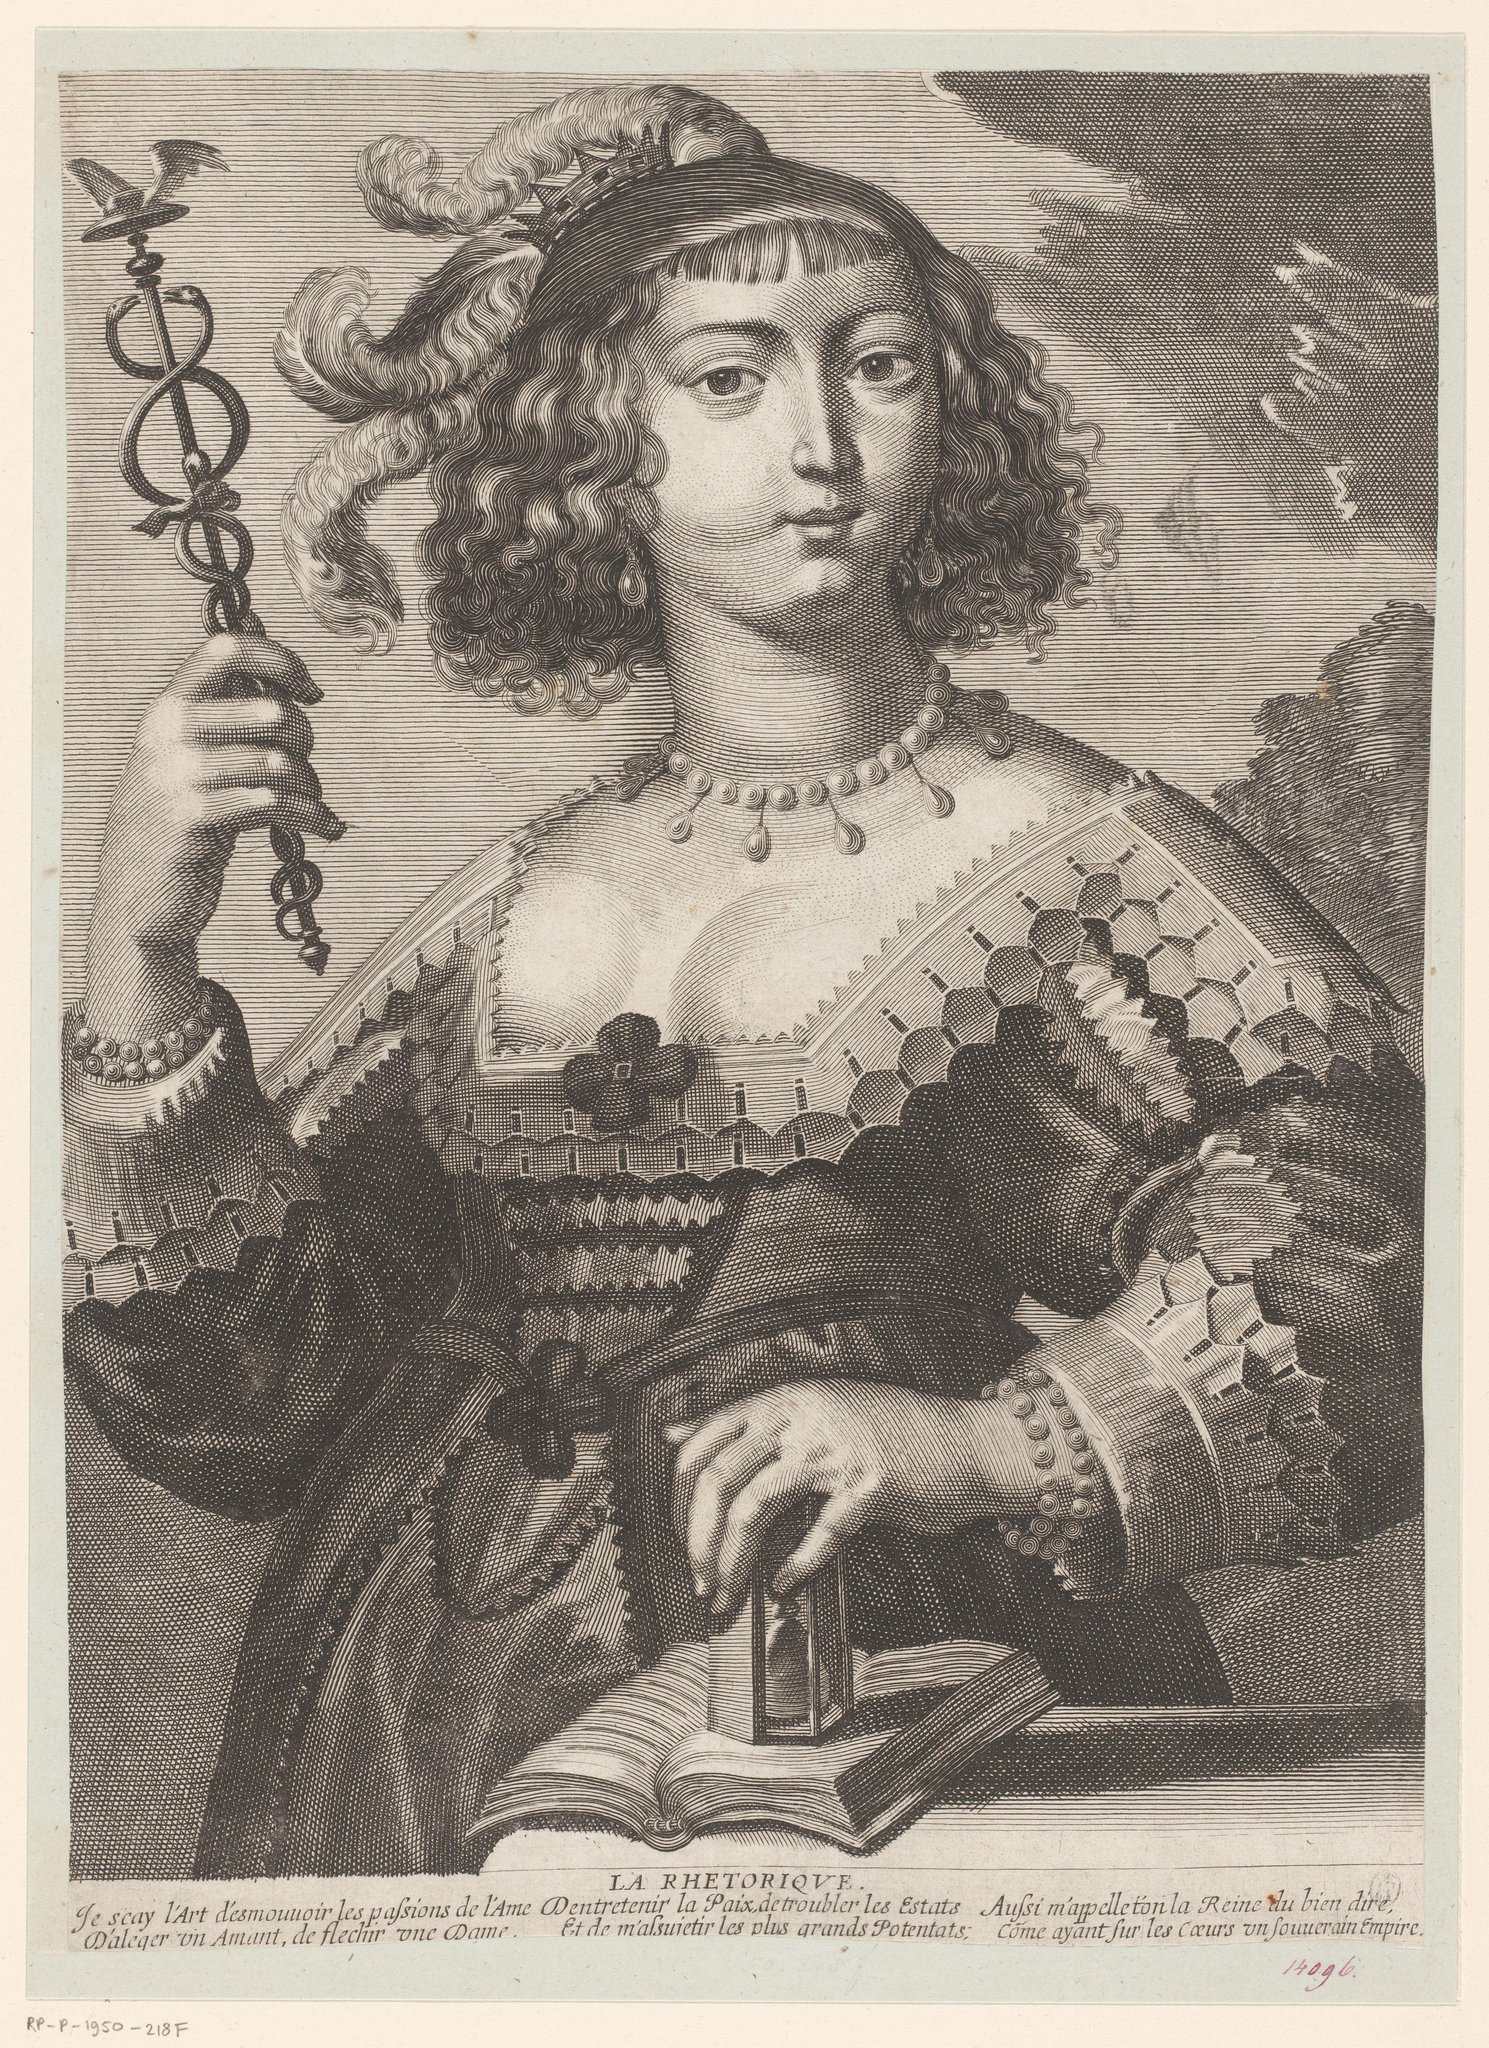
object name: print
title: Retorica (Welsprekendheid)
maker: jean baptiste humbelot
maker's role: print maker, publisher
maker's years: 1600-1685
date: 1600-1685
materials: paper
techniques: engraving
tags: 'rhetorica', 'eloquentia' (~ trivium); 'rettorica' (ripa)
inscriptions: number: ‘14096.’, collector's mark: Lugt 971, collector's mark: Lugt 2228